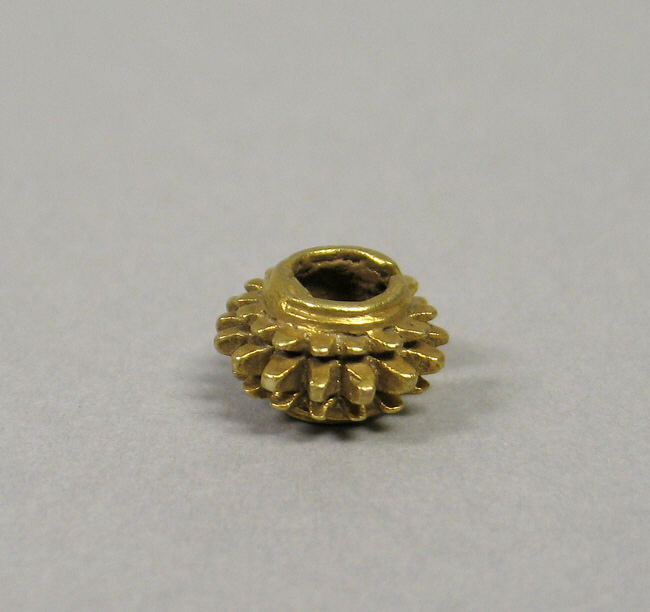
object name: ear ornament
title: Ear Ornament, Rows of Teeth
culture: indonesian, central java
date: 701-1200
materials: gold